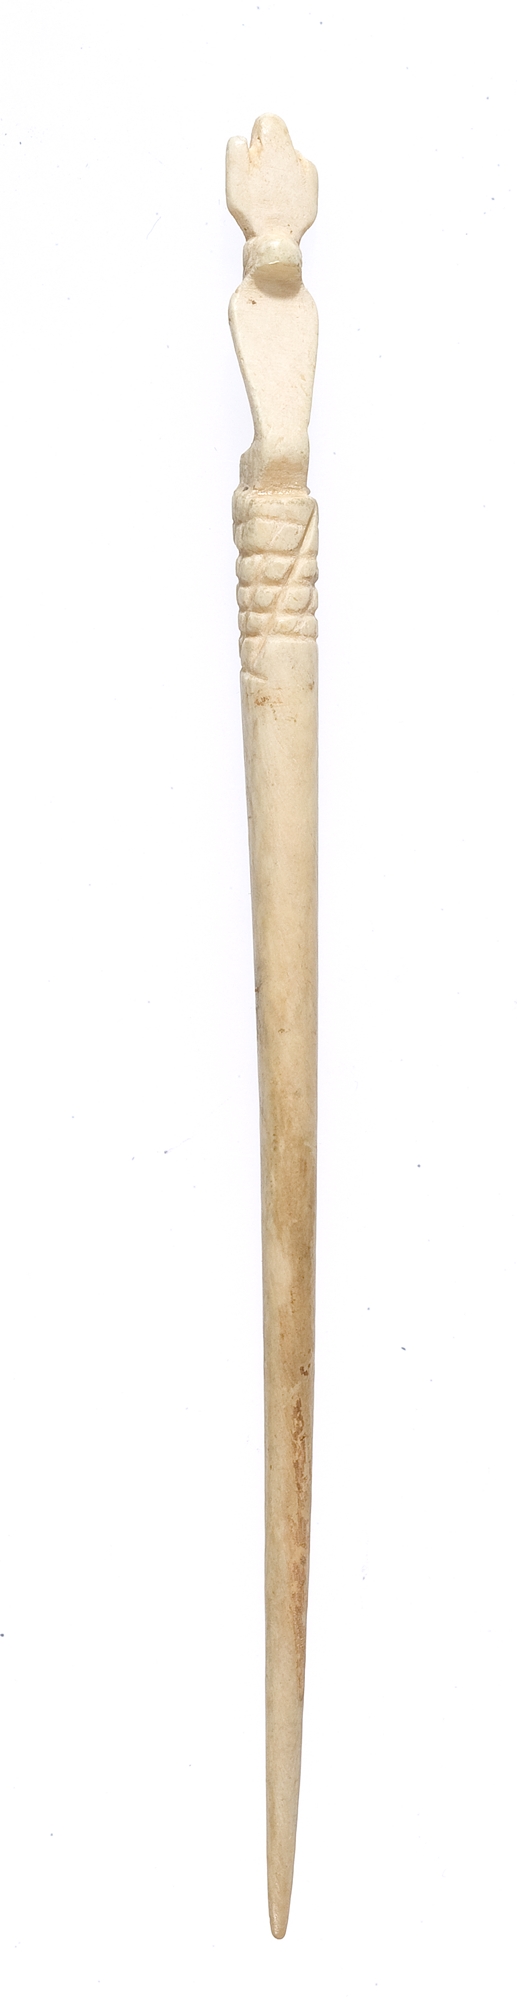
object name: hair pin, ivory, cobra, uraeus, sun disk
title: Hairpin Decorated with a Cobra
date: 1783-1640 BCE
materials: ivory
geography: egypt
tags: snakes